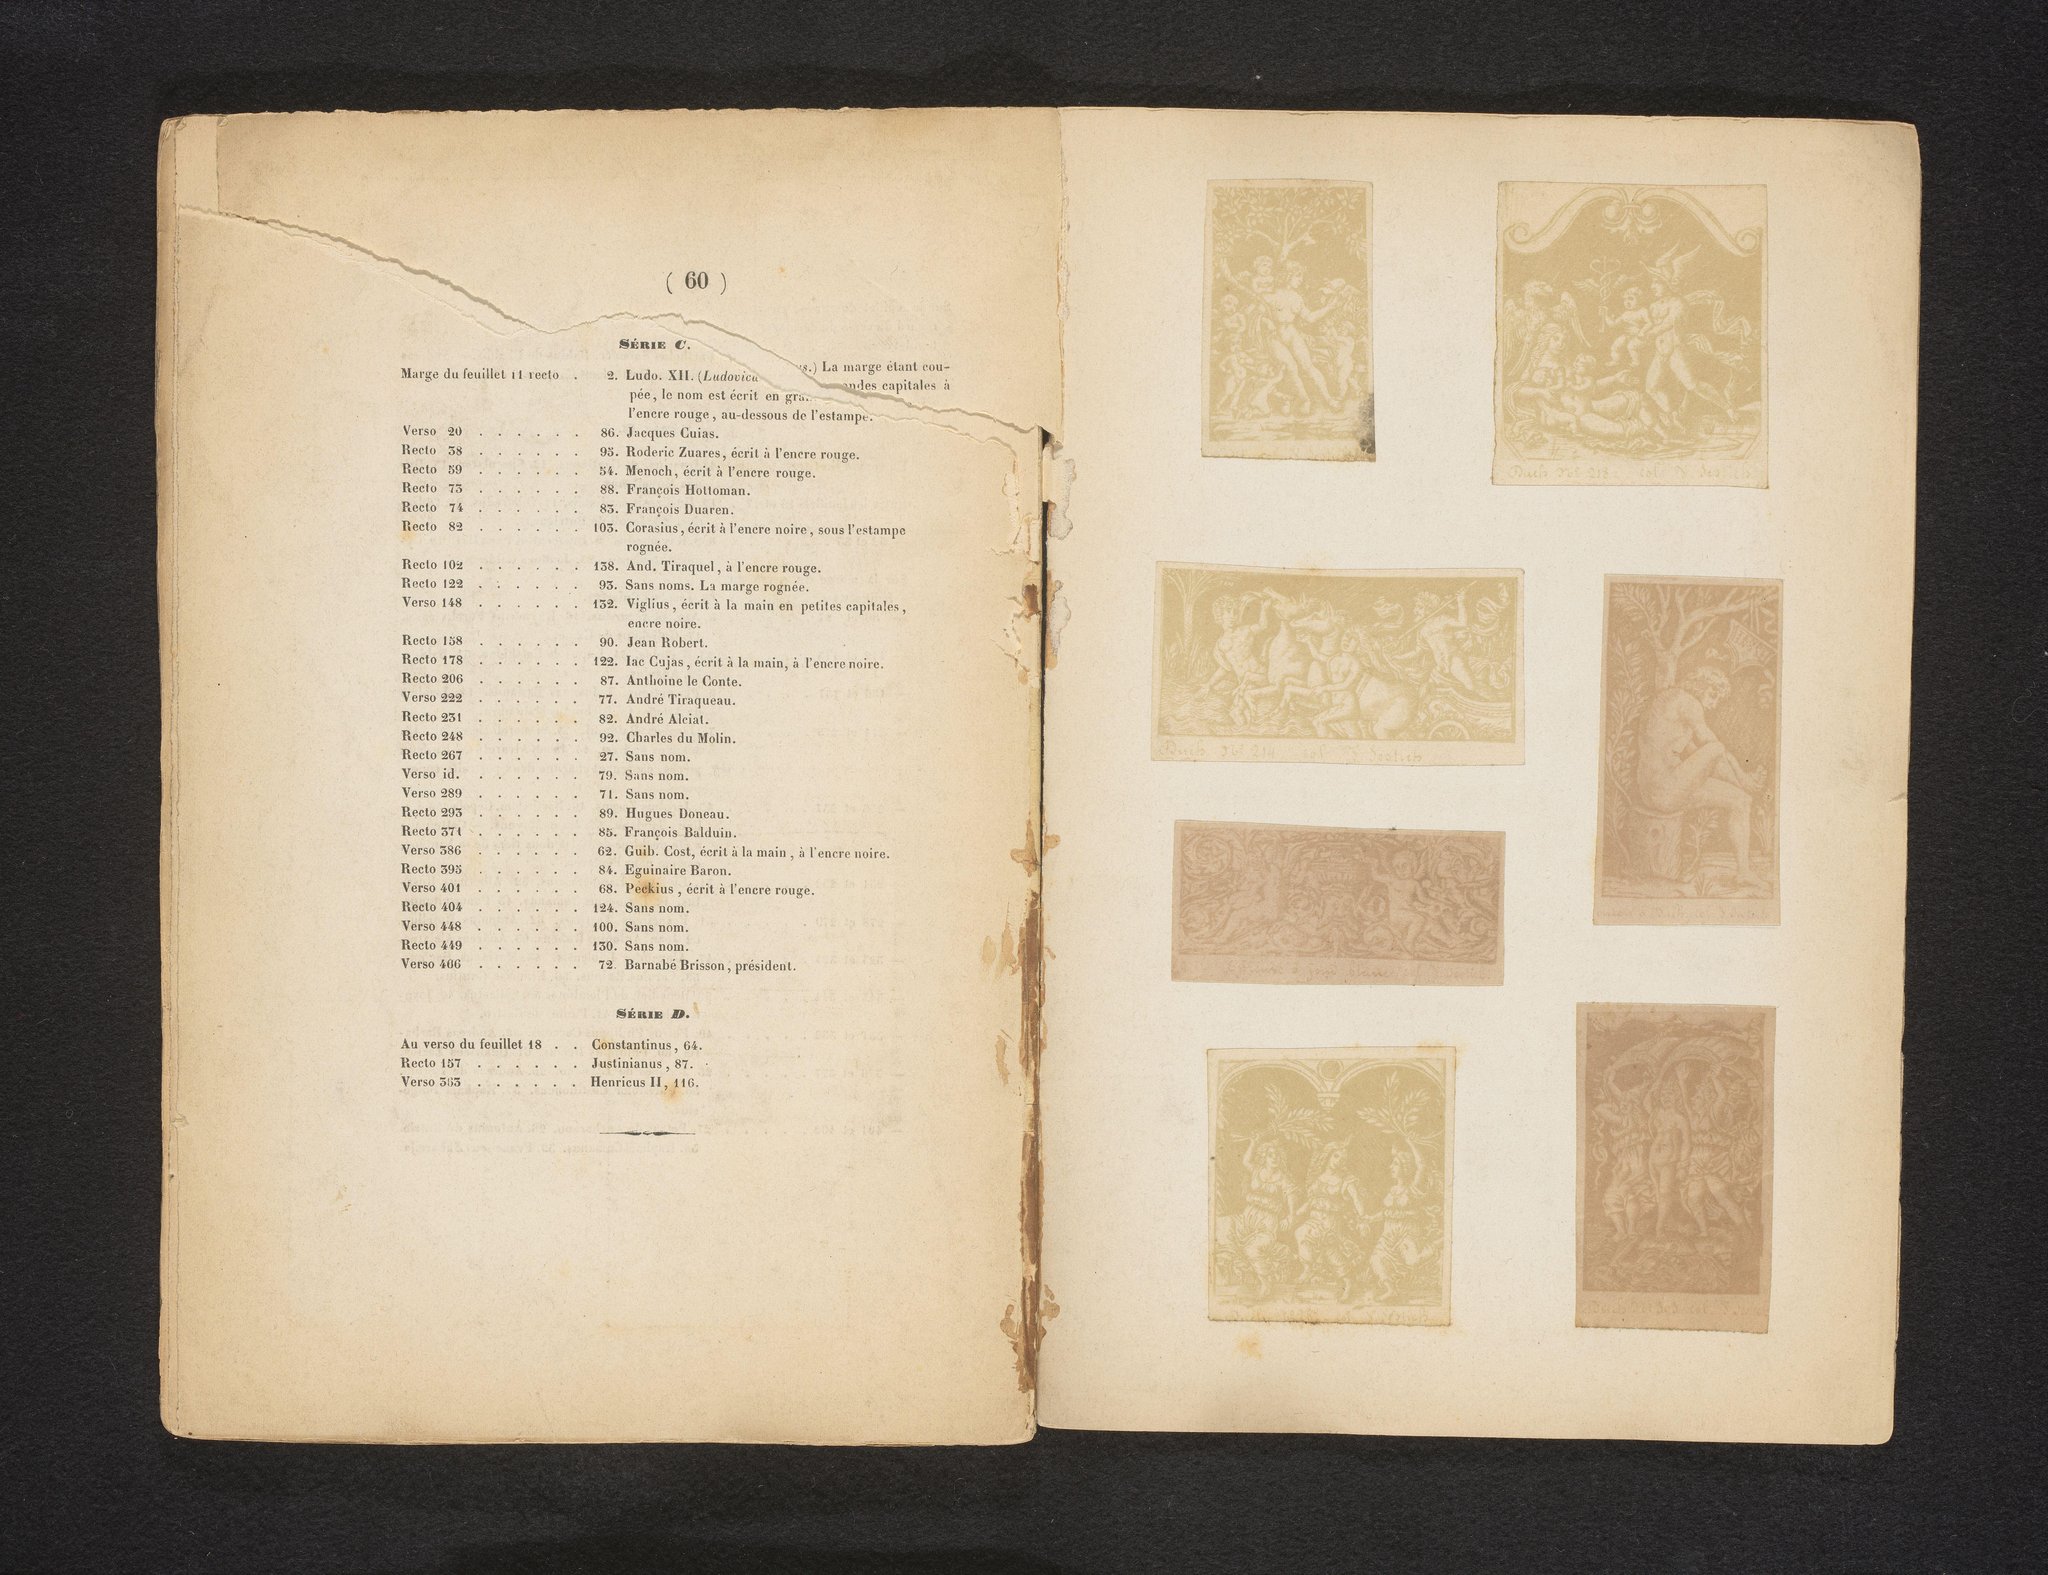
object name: page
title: Fotoreproductie van een prent van een allegorie op de navigatie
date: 1852-1857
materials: photographic support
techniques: salted paper print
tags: signalling ~ navigation, symbolic representations, allegories and emblems ~ drawing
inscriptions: inscription: ‘Duch. No. 303. col. V. Sestich’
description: Foto op blad met zeven foto's tegenover pagina 60.